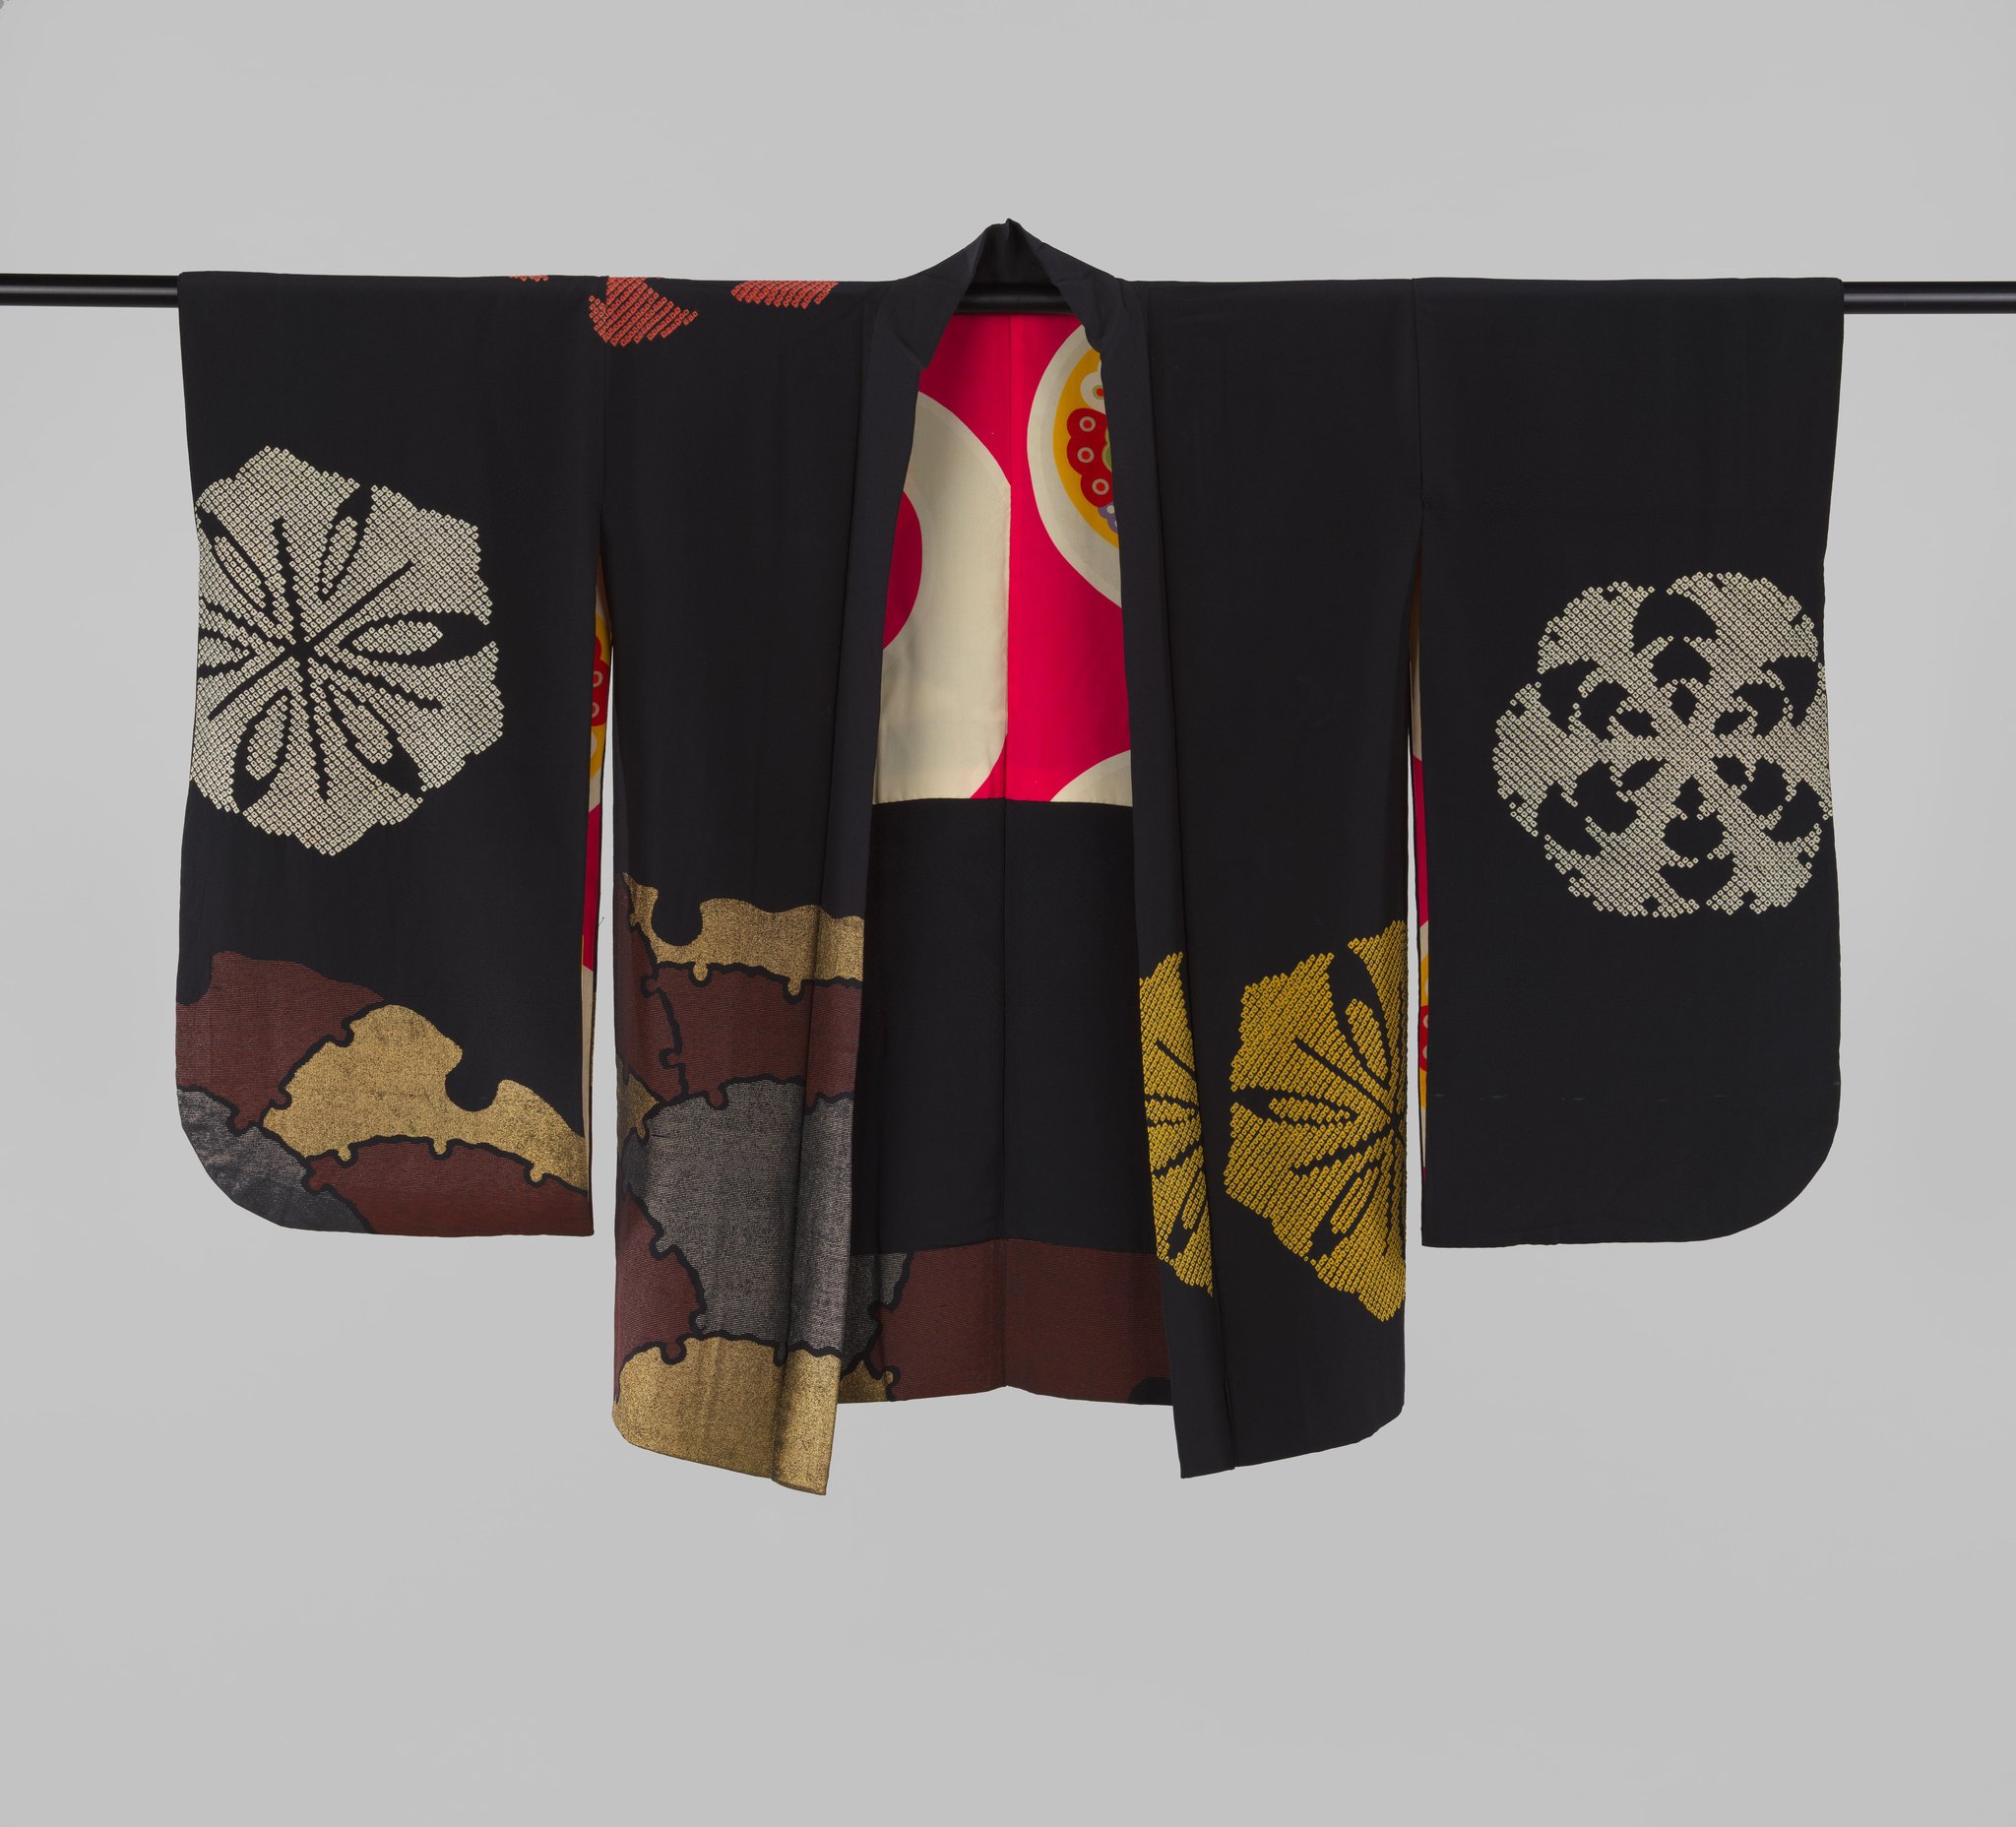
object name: kimono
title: Vrouwen haori met sneeuwkristallen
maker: Anonymous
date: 1920-1940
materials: silk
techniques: painting, weave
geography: japan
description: Haori voor een vrouw met een versiering over het hele vlak van grote sneeuwkristal-motieven in rood, wit, goud, zilver en zwart. Zwarte fijne crêpe zijde (kinsha) met decoratie in tie-dye (shibori) en additioneel geweven versiering met goud-, zilver- en lakstrips. Enkel familiewapen (mon) van klaverzuring (katabami).